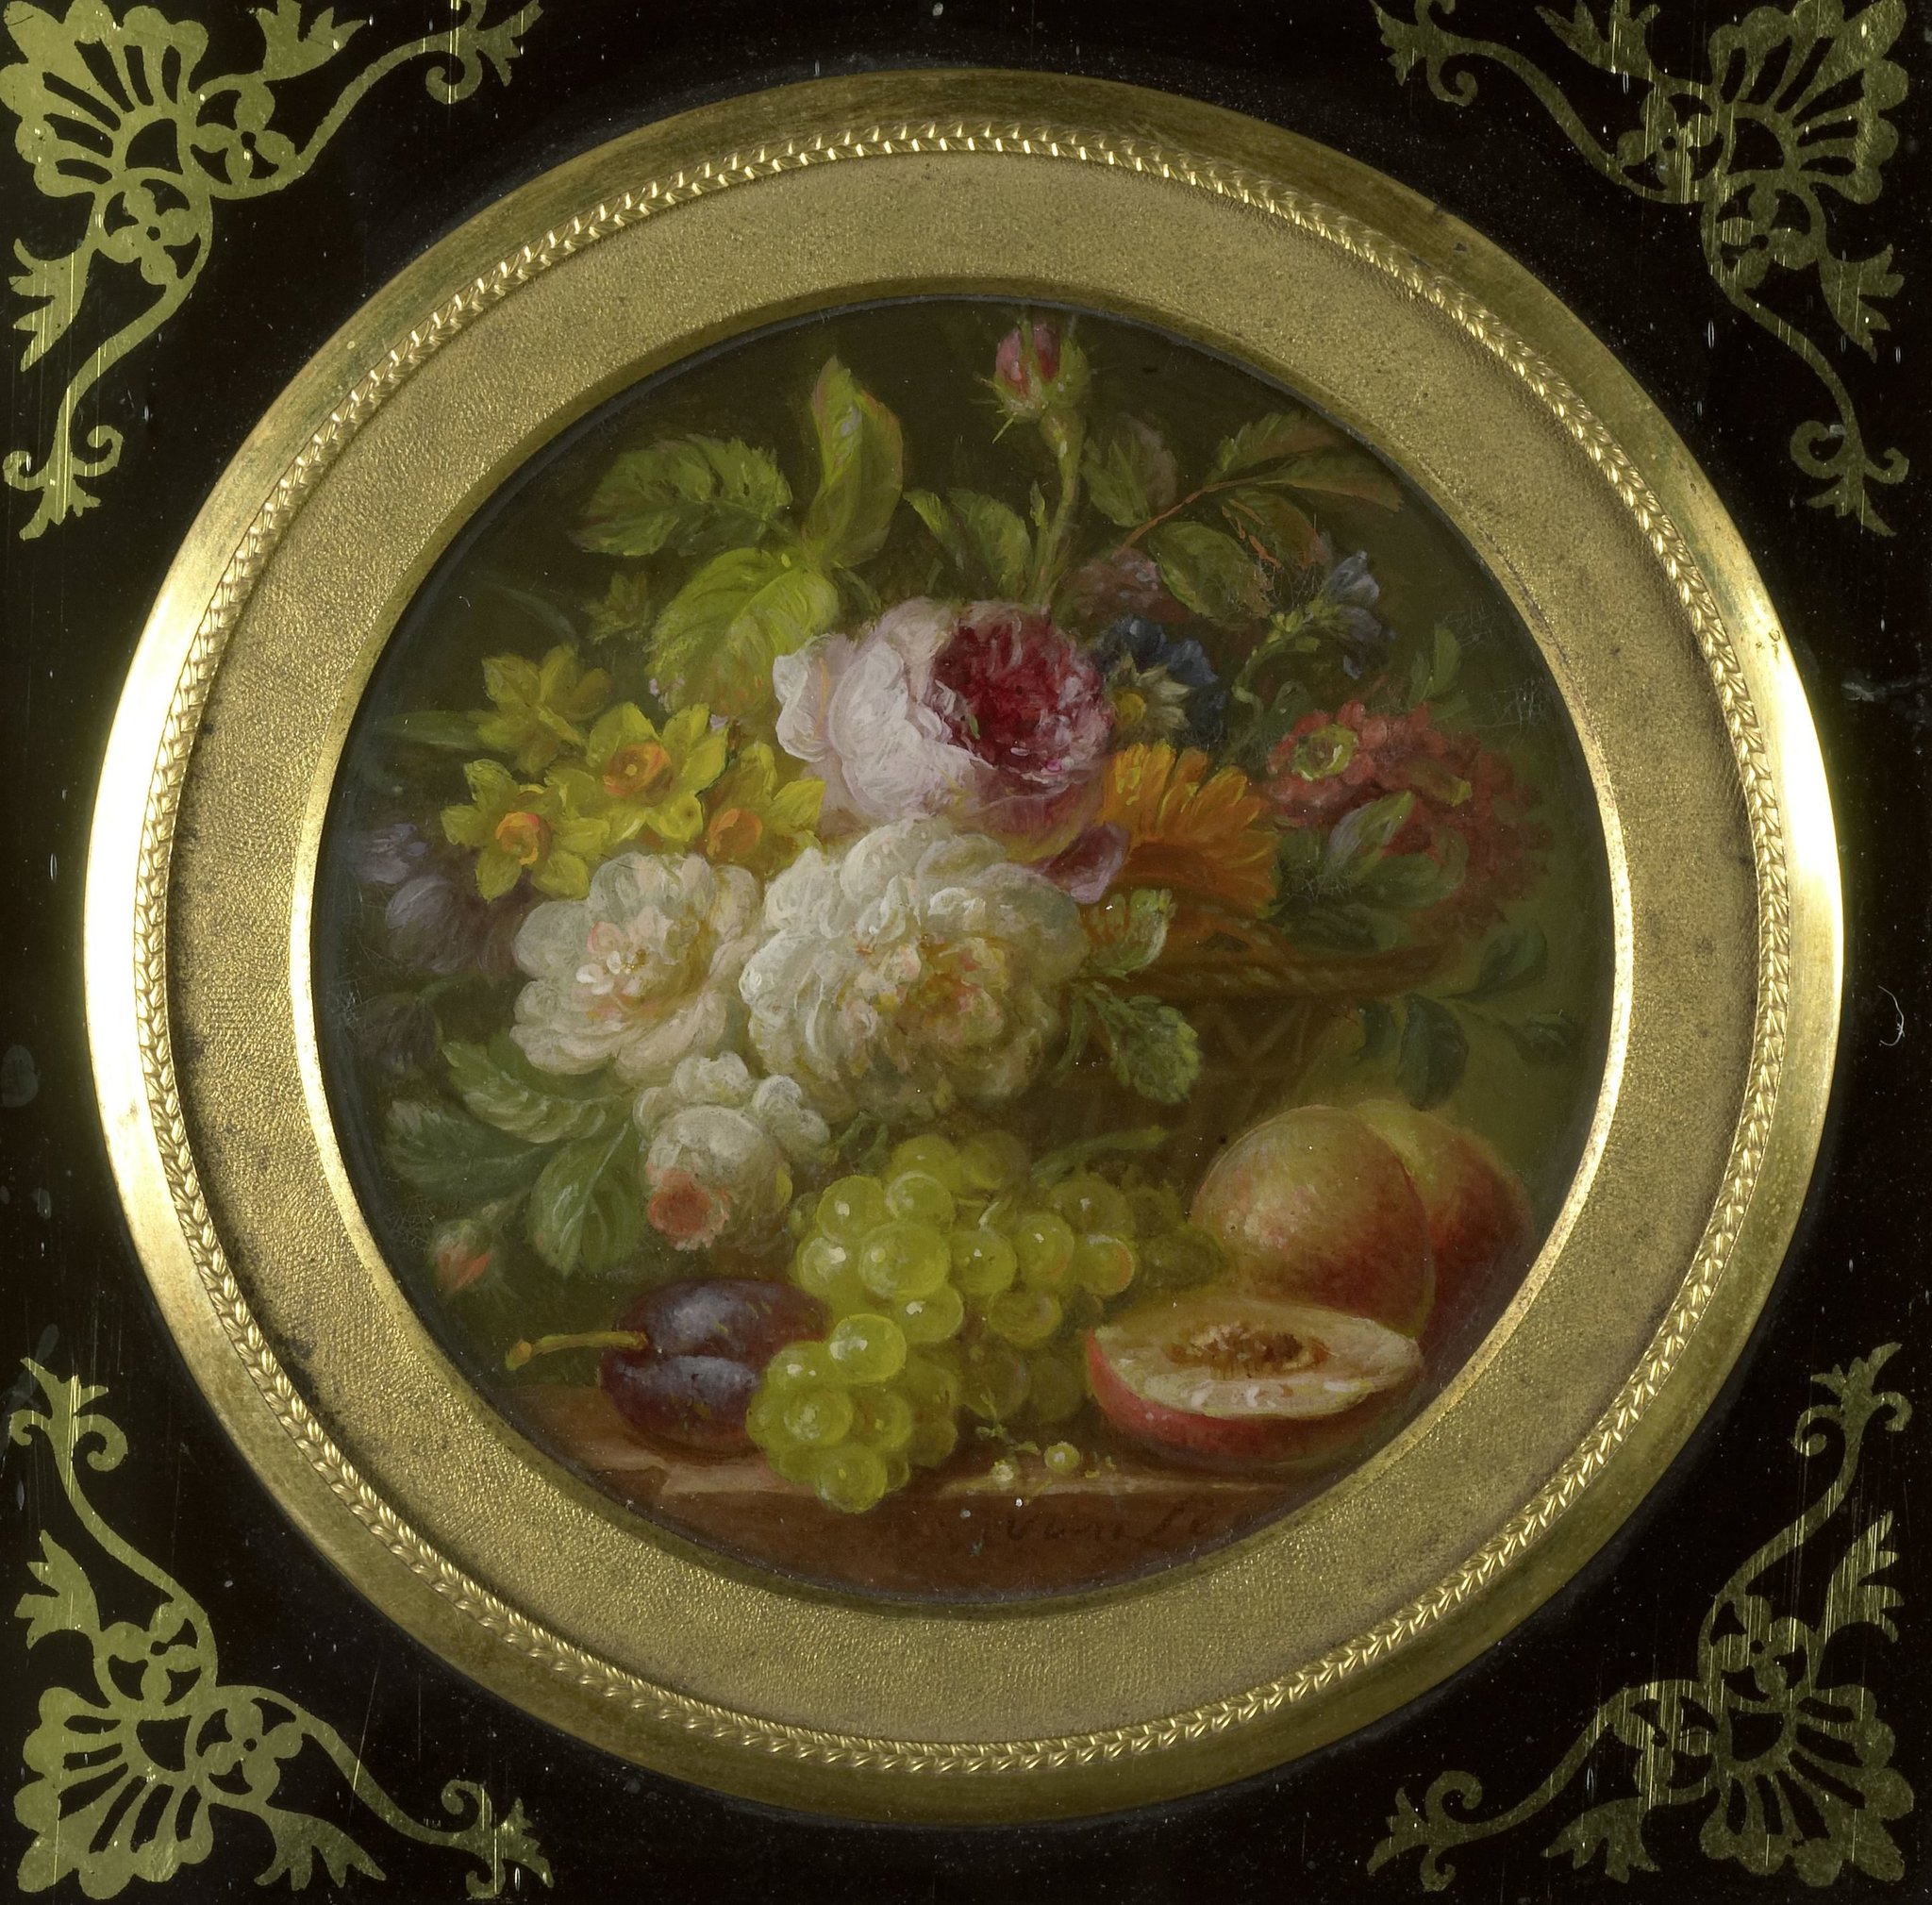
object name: reverse painting on glass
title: Still Life with Flowers and Fruits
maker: willem van leen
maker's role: draughtsman, print maker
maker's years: 1753-1825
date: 1780-1810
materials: glass, leather, metal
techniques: verre églomisé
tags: still life of plants, flowers and fruit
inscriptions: signature: ‘W Van Leen’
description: Willem van Leen (1753 - 1825). Still life with flowers and fruits. Verre eglomisé. Mr and Mrs J.C.J. Drucker-Fraser bequest, Montreux, 1944.